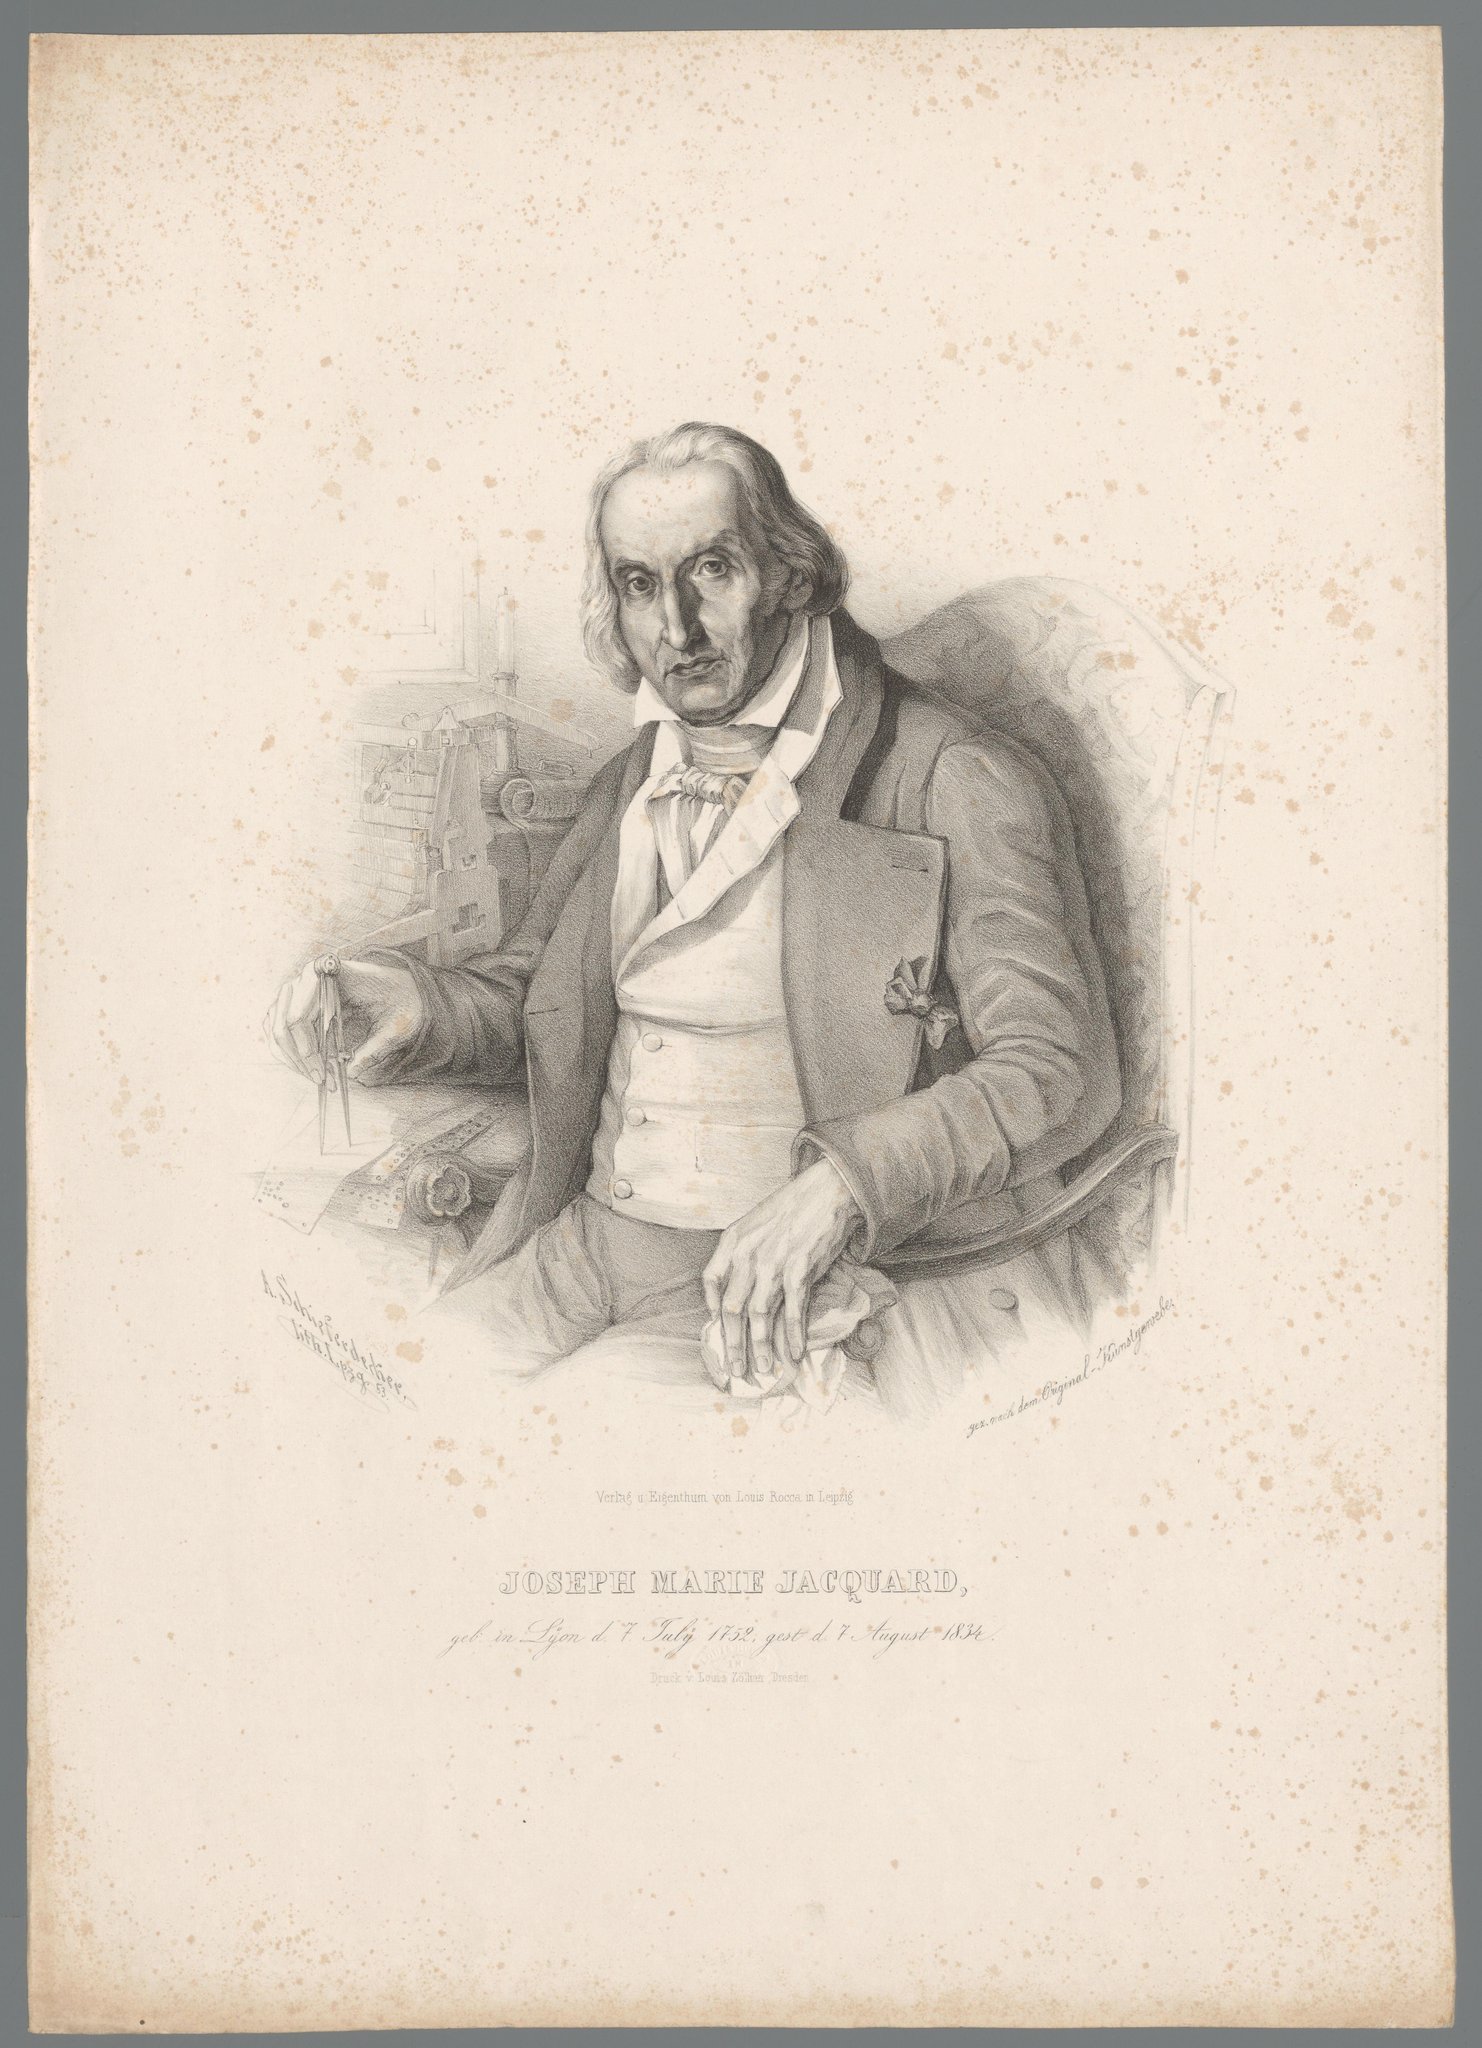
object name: print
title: Portret van Joseph Marie Jacquard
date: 1853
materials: paper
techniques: lithograph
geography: leipzig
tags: joseph marie jacquard, historical persons, persons engaged in trade and commerce, craftsman ~ applied arts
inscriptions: check stamp: ‘Louis Rocca in Leipzig’, collector's mark: Lugt 2228